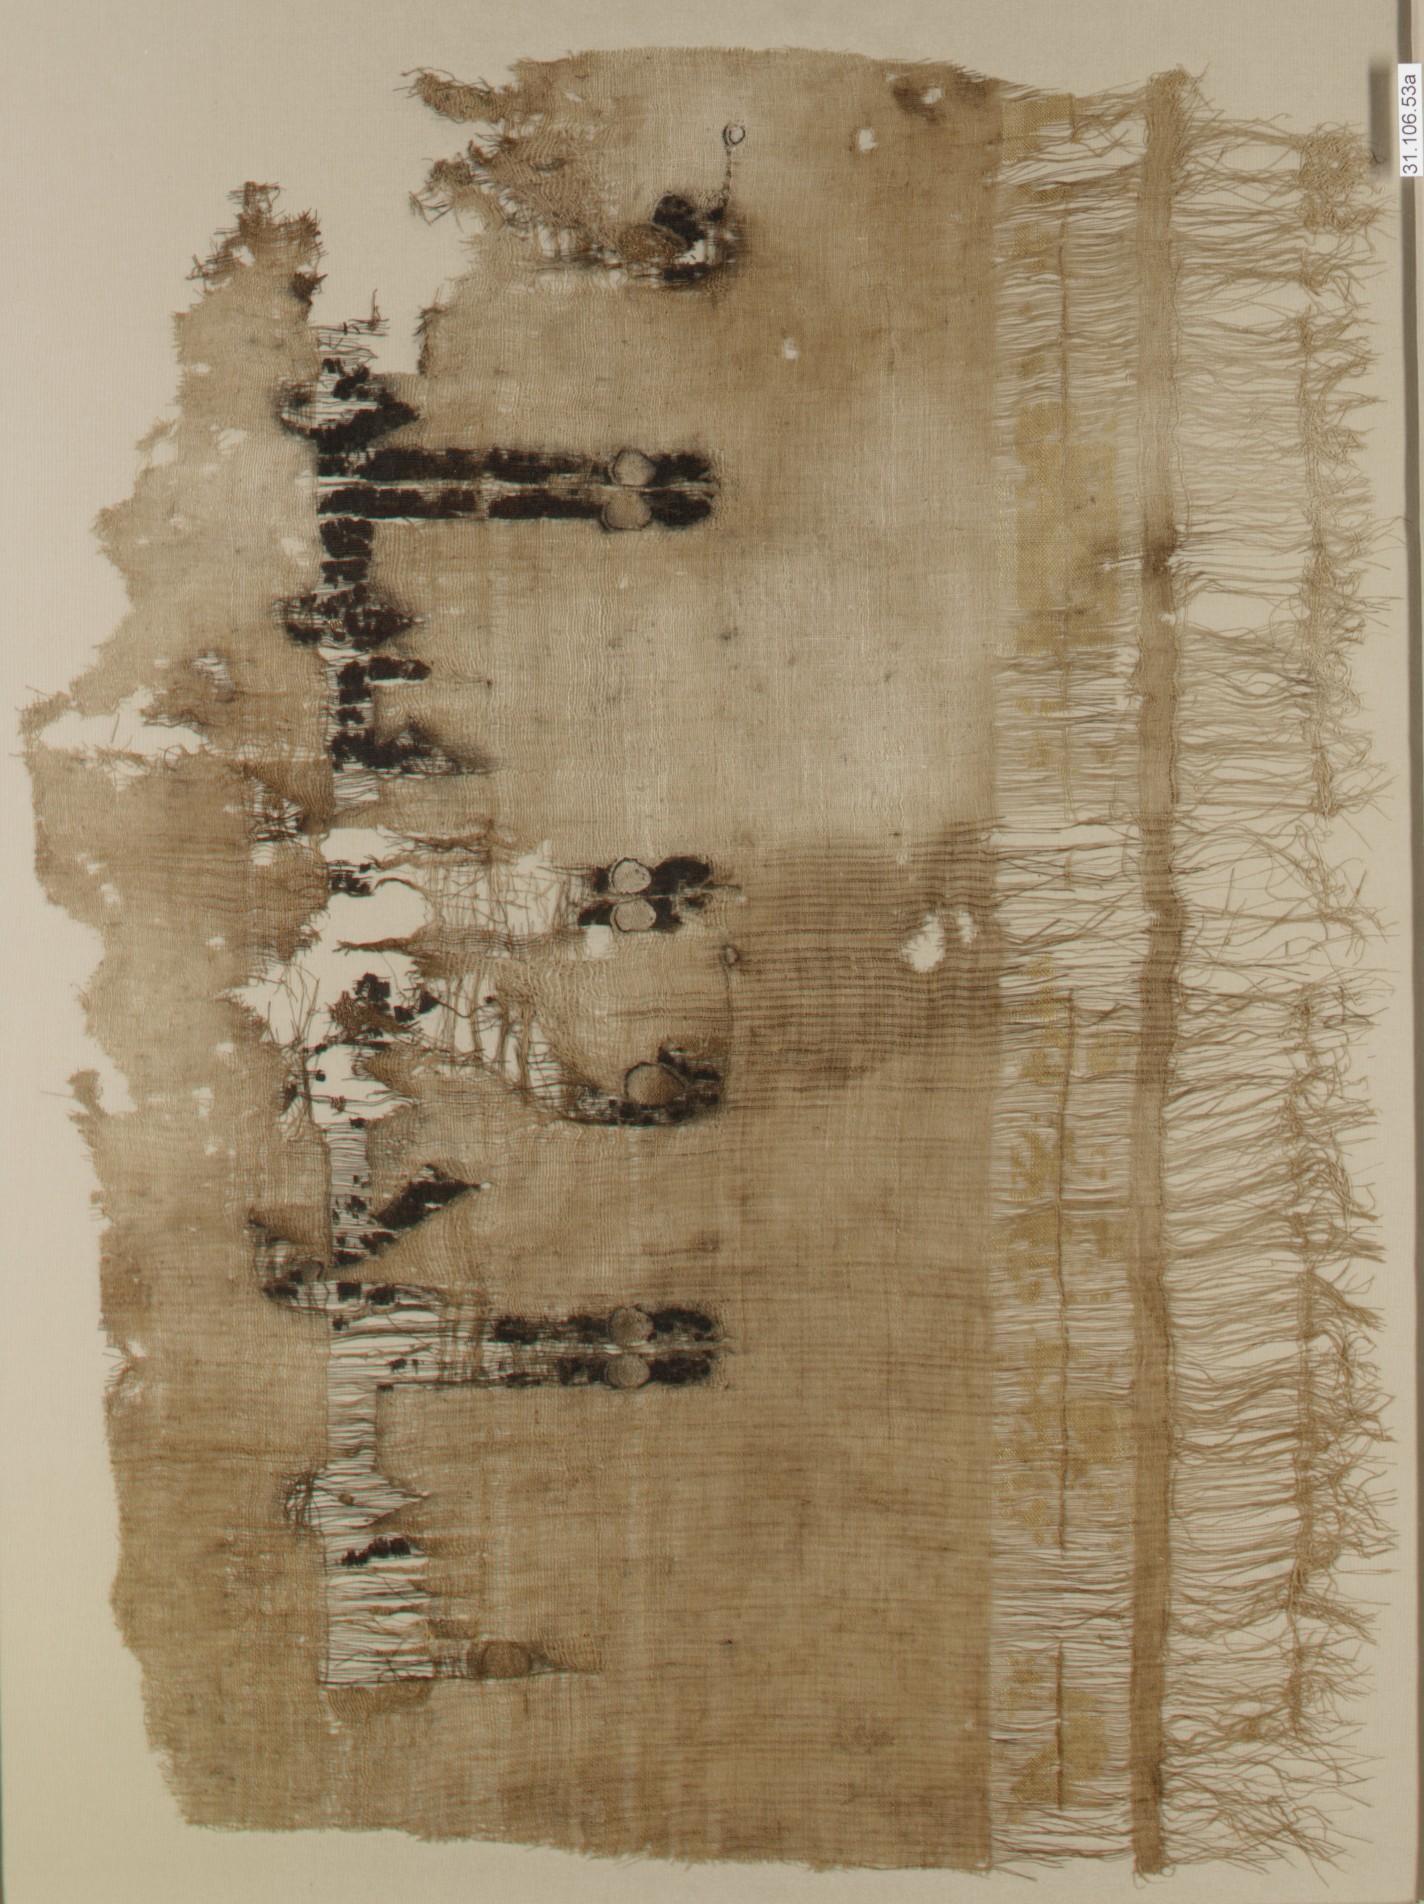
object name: textile fragment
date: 946-974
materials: linen, silk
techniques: weave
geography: egypt